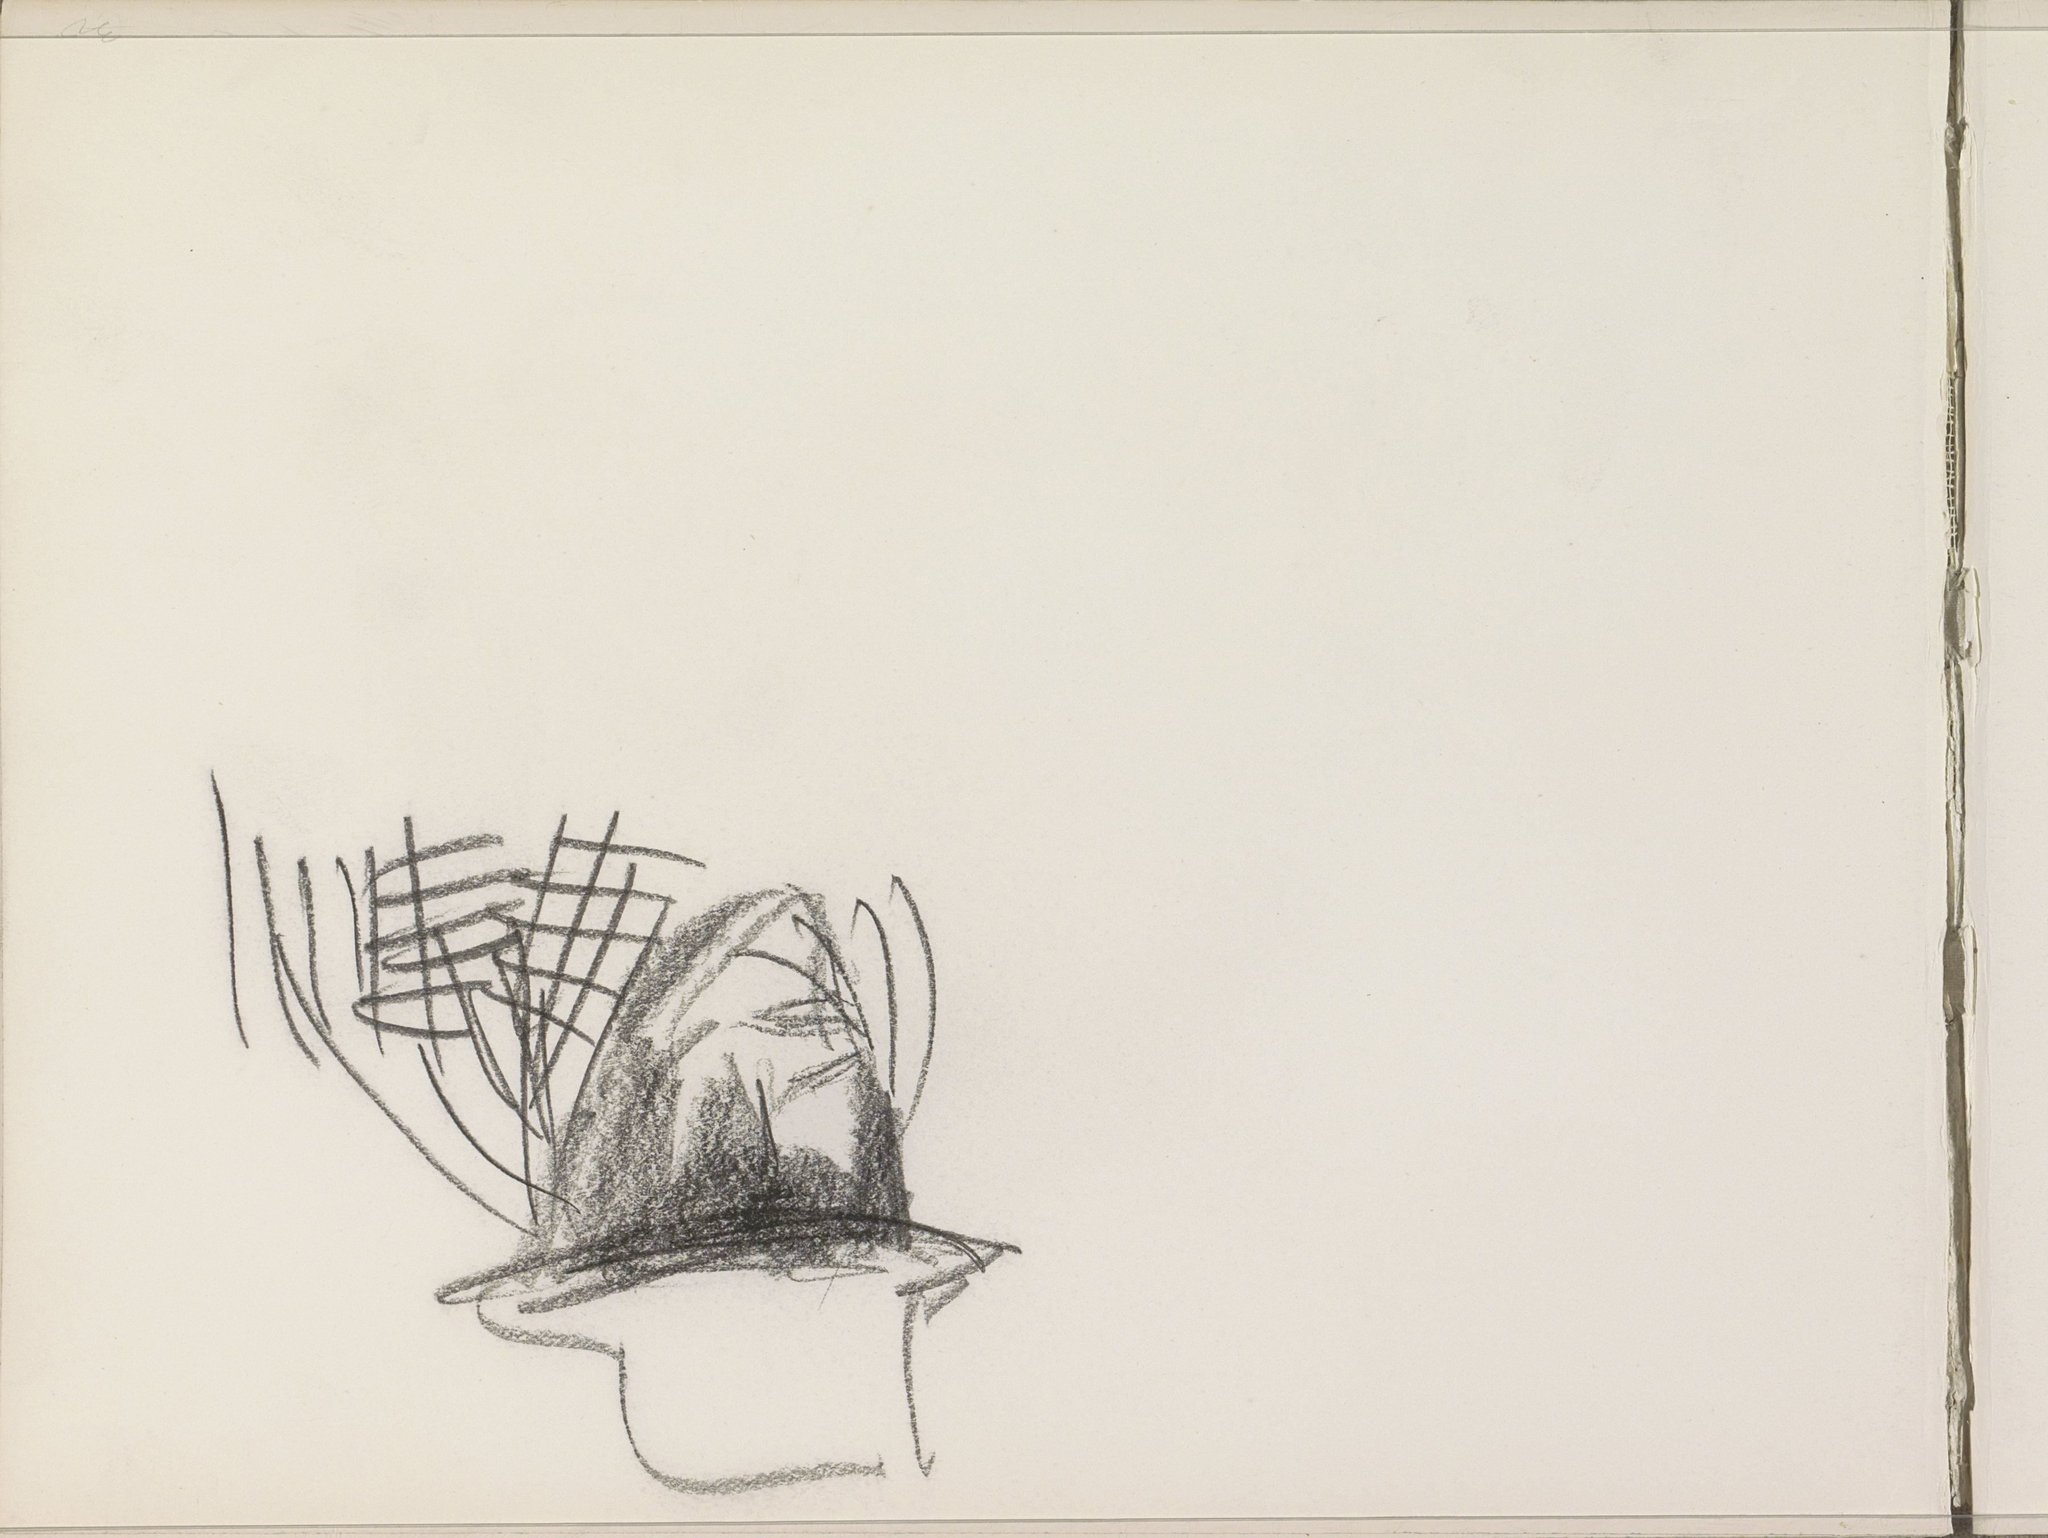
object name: sketchbook leaf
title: Mannenhoofd met hoed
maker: isaac israels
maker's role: draughtsman, painter, print maker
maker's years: 1865-1934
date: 1875-1934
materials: chalk, paper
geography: the hague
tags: adult man, head-gear: hat (+ men's clothes)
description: Blad 23 verso uit schetsboek VII met 26 bladen.